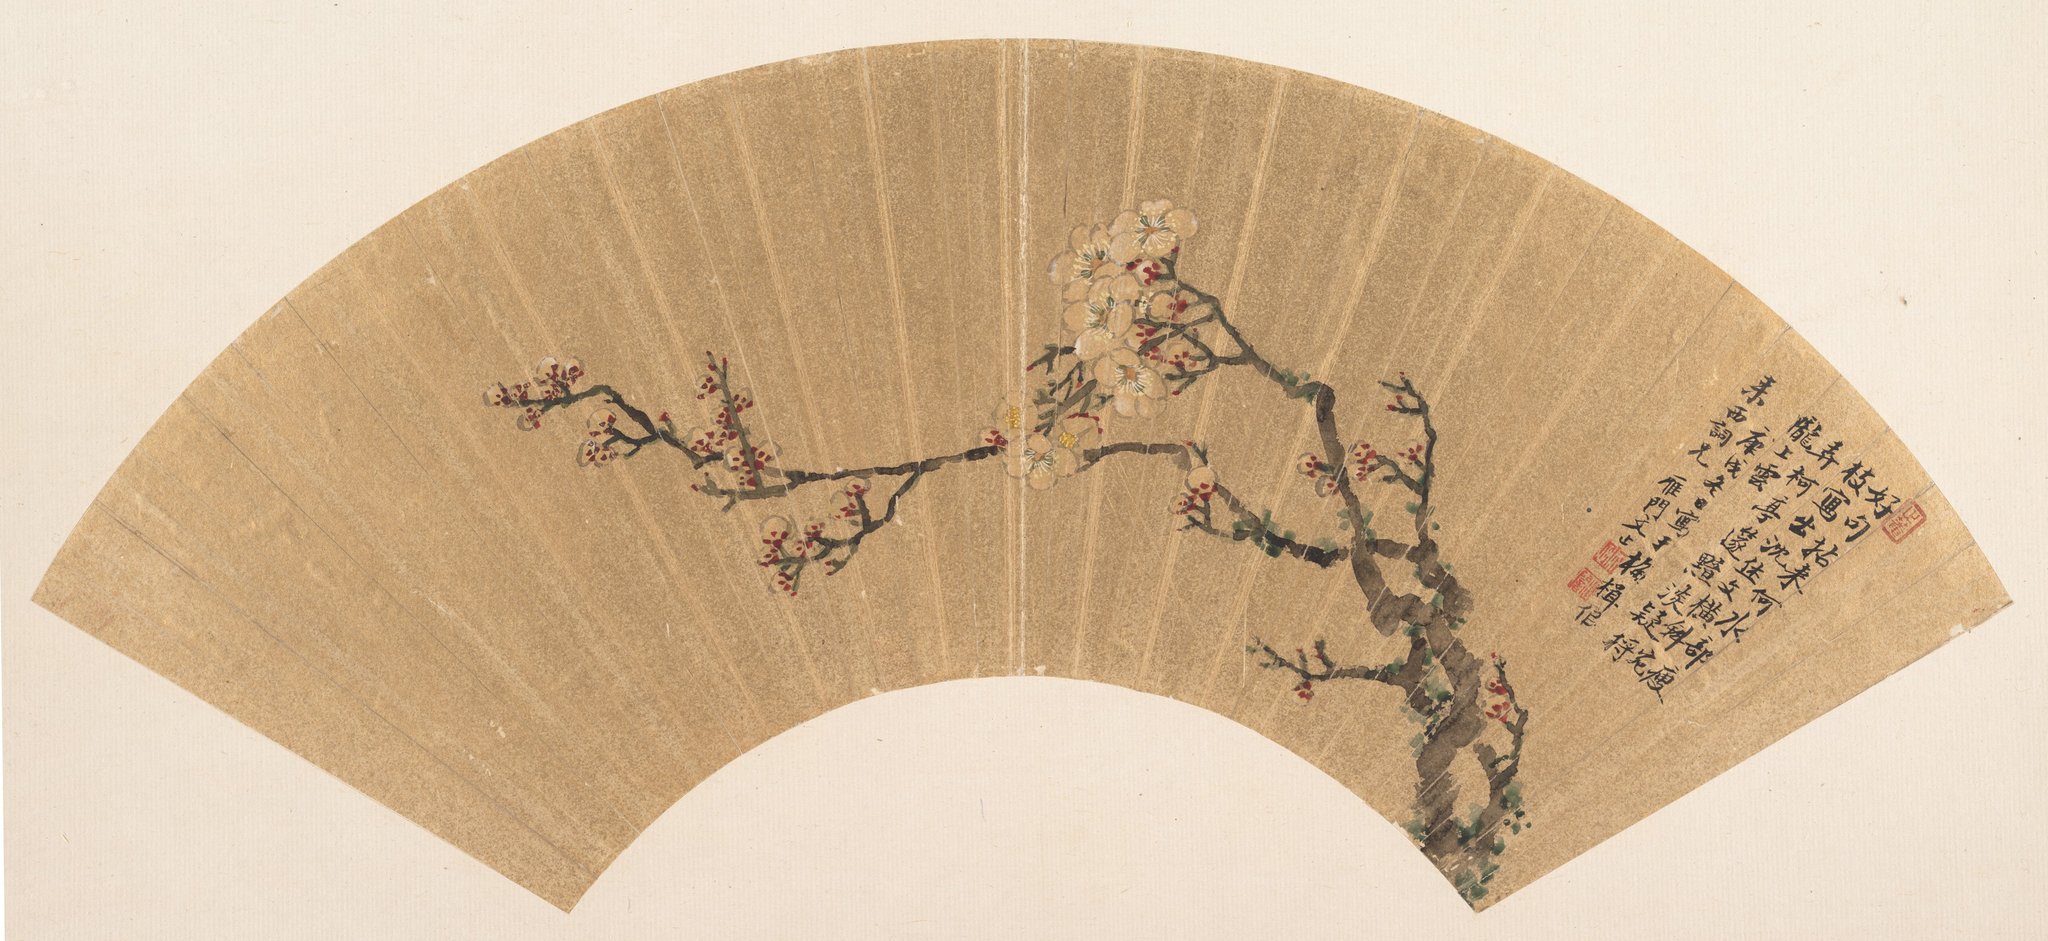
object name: folding fan mounted a an album leaf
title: Plum Blossoms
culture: chinese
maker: wen zhi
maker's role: artist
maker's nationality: chinese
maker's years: 1634-1699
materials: gold, ink, paper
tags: flowers